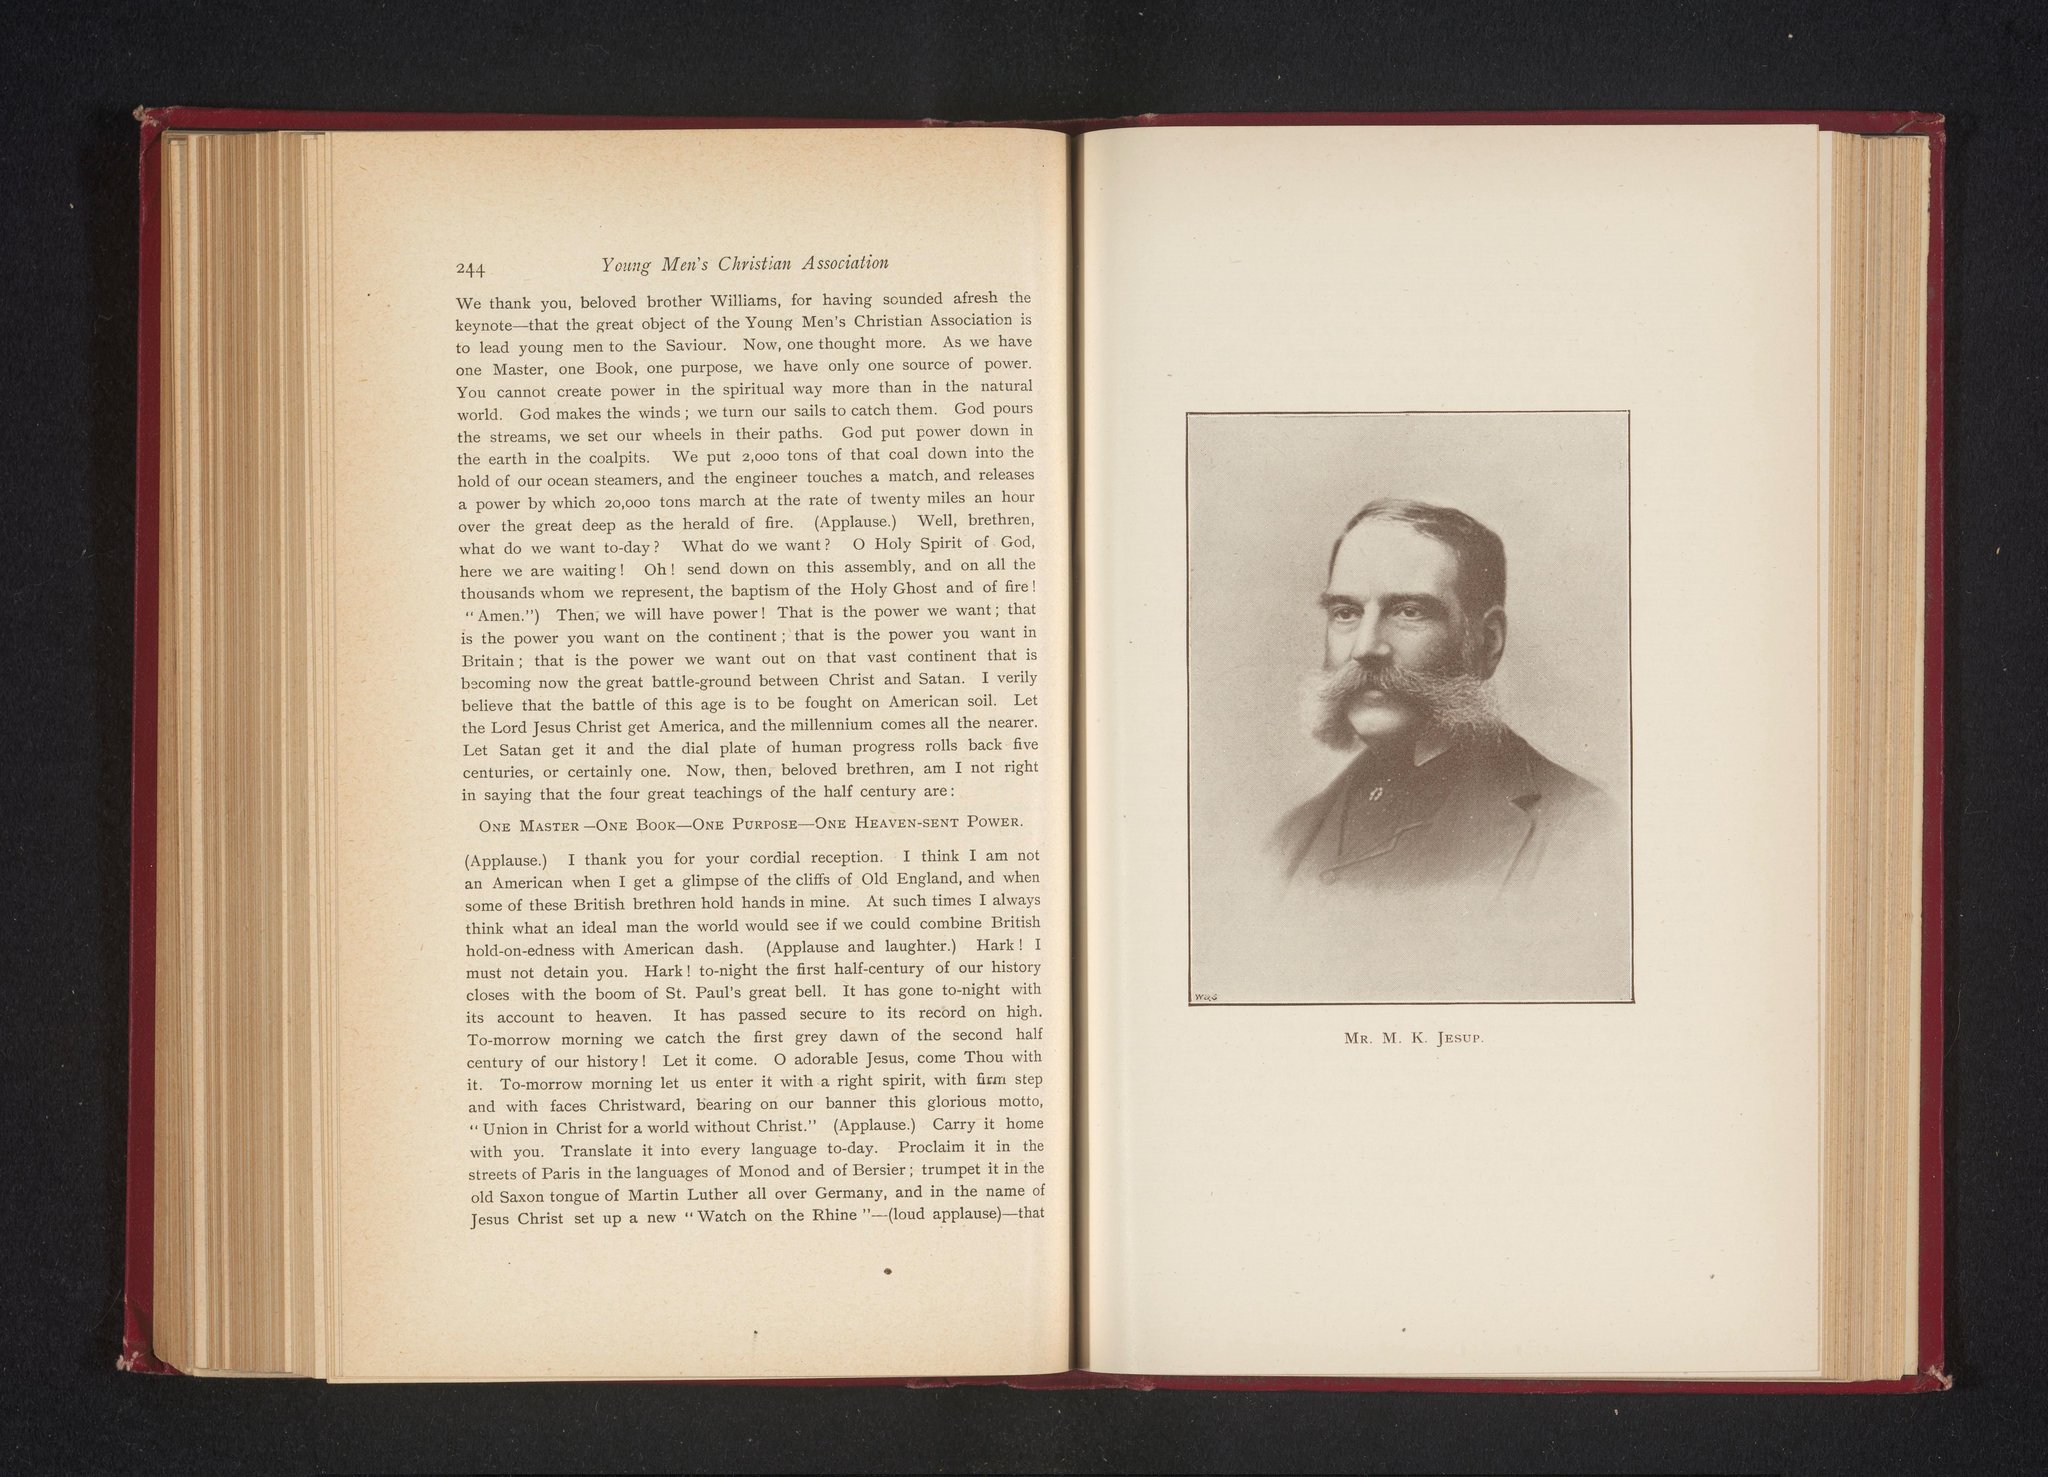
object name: photomechanical print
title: Portret van Morris Ketchum Jesup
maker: Anonymous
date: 1890-1895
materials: paper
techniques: autotype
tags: new york (city), historical persons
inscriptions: monogram: ‘W&S’